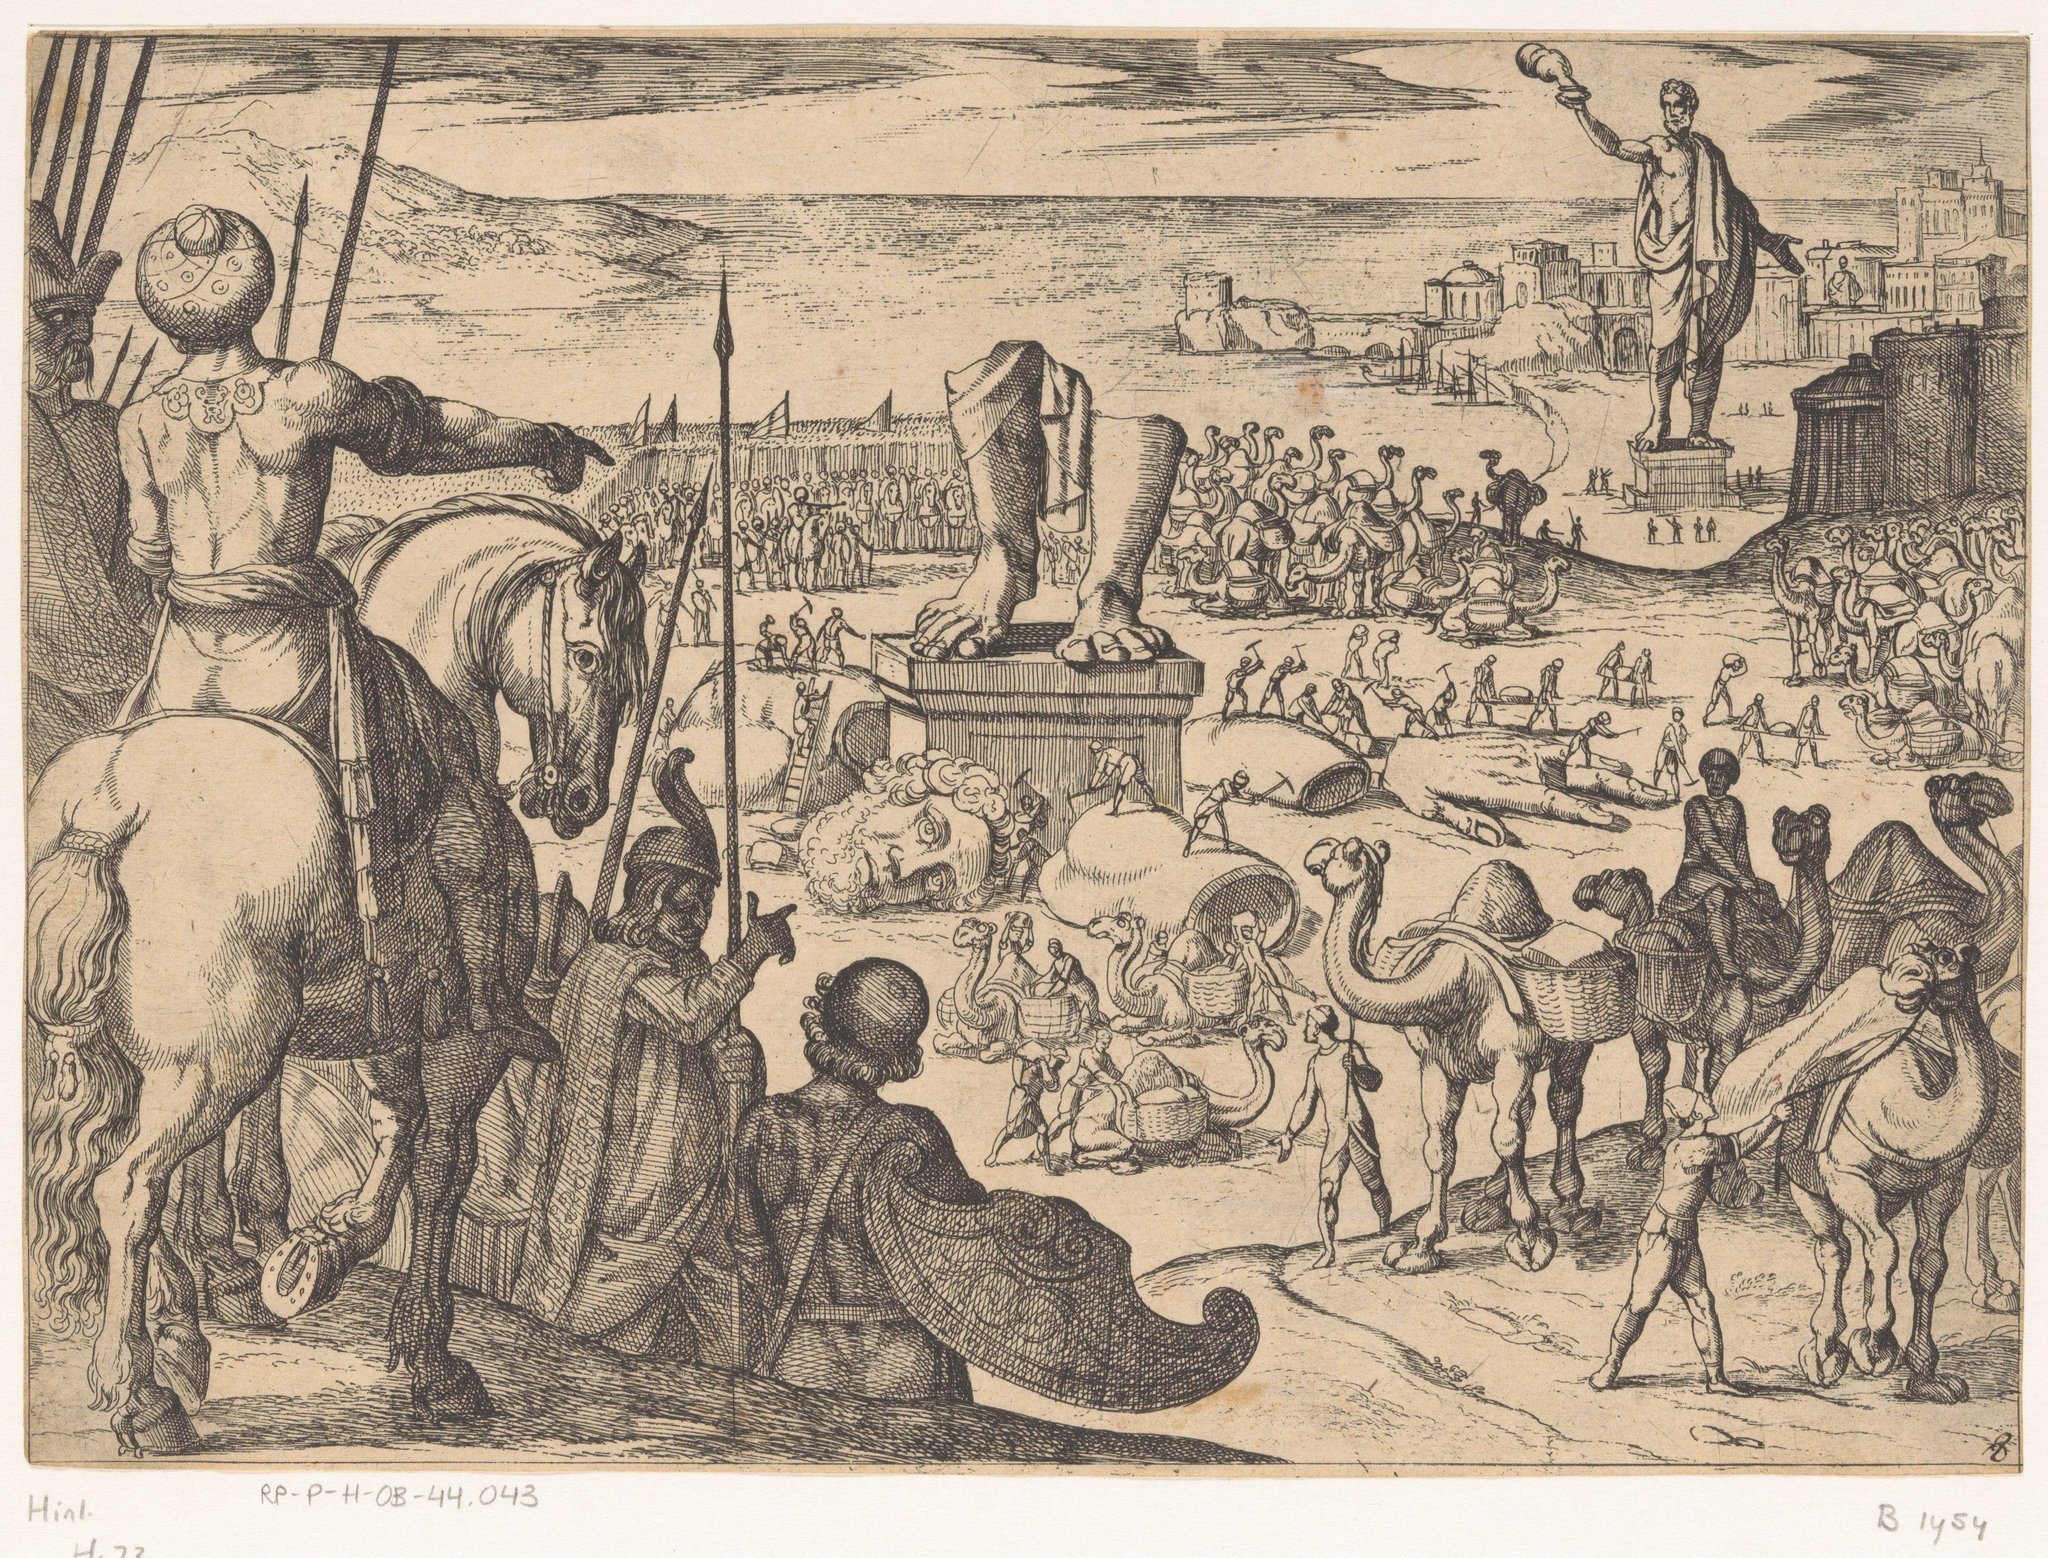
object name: print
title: Septem orbis admiranda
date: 1608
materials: paper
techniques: etching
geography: antwerp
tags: hoofed animals: camel, the seven wonders of the world, colossus of rhodes (wonder of the world)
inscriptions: collector's mark: Lugt 11, collector's mark: ‘Hinloopen’, number: ‘8’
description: Gezicht op het strand van Rhodos. Op het strand staan een leger, werklui en kamelen. Op de achtergrond staat het grote bronzen beeld de Kolos van Rhodos. Op de voorgrond wordt een tweede beeld geplaatst.